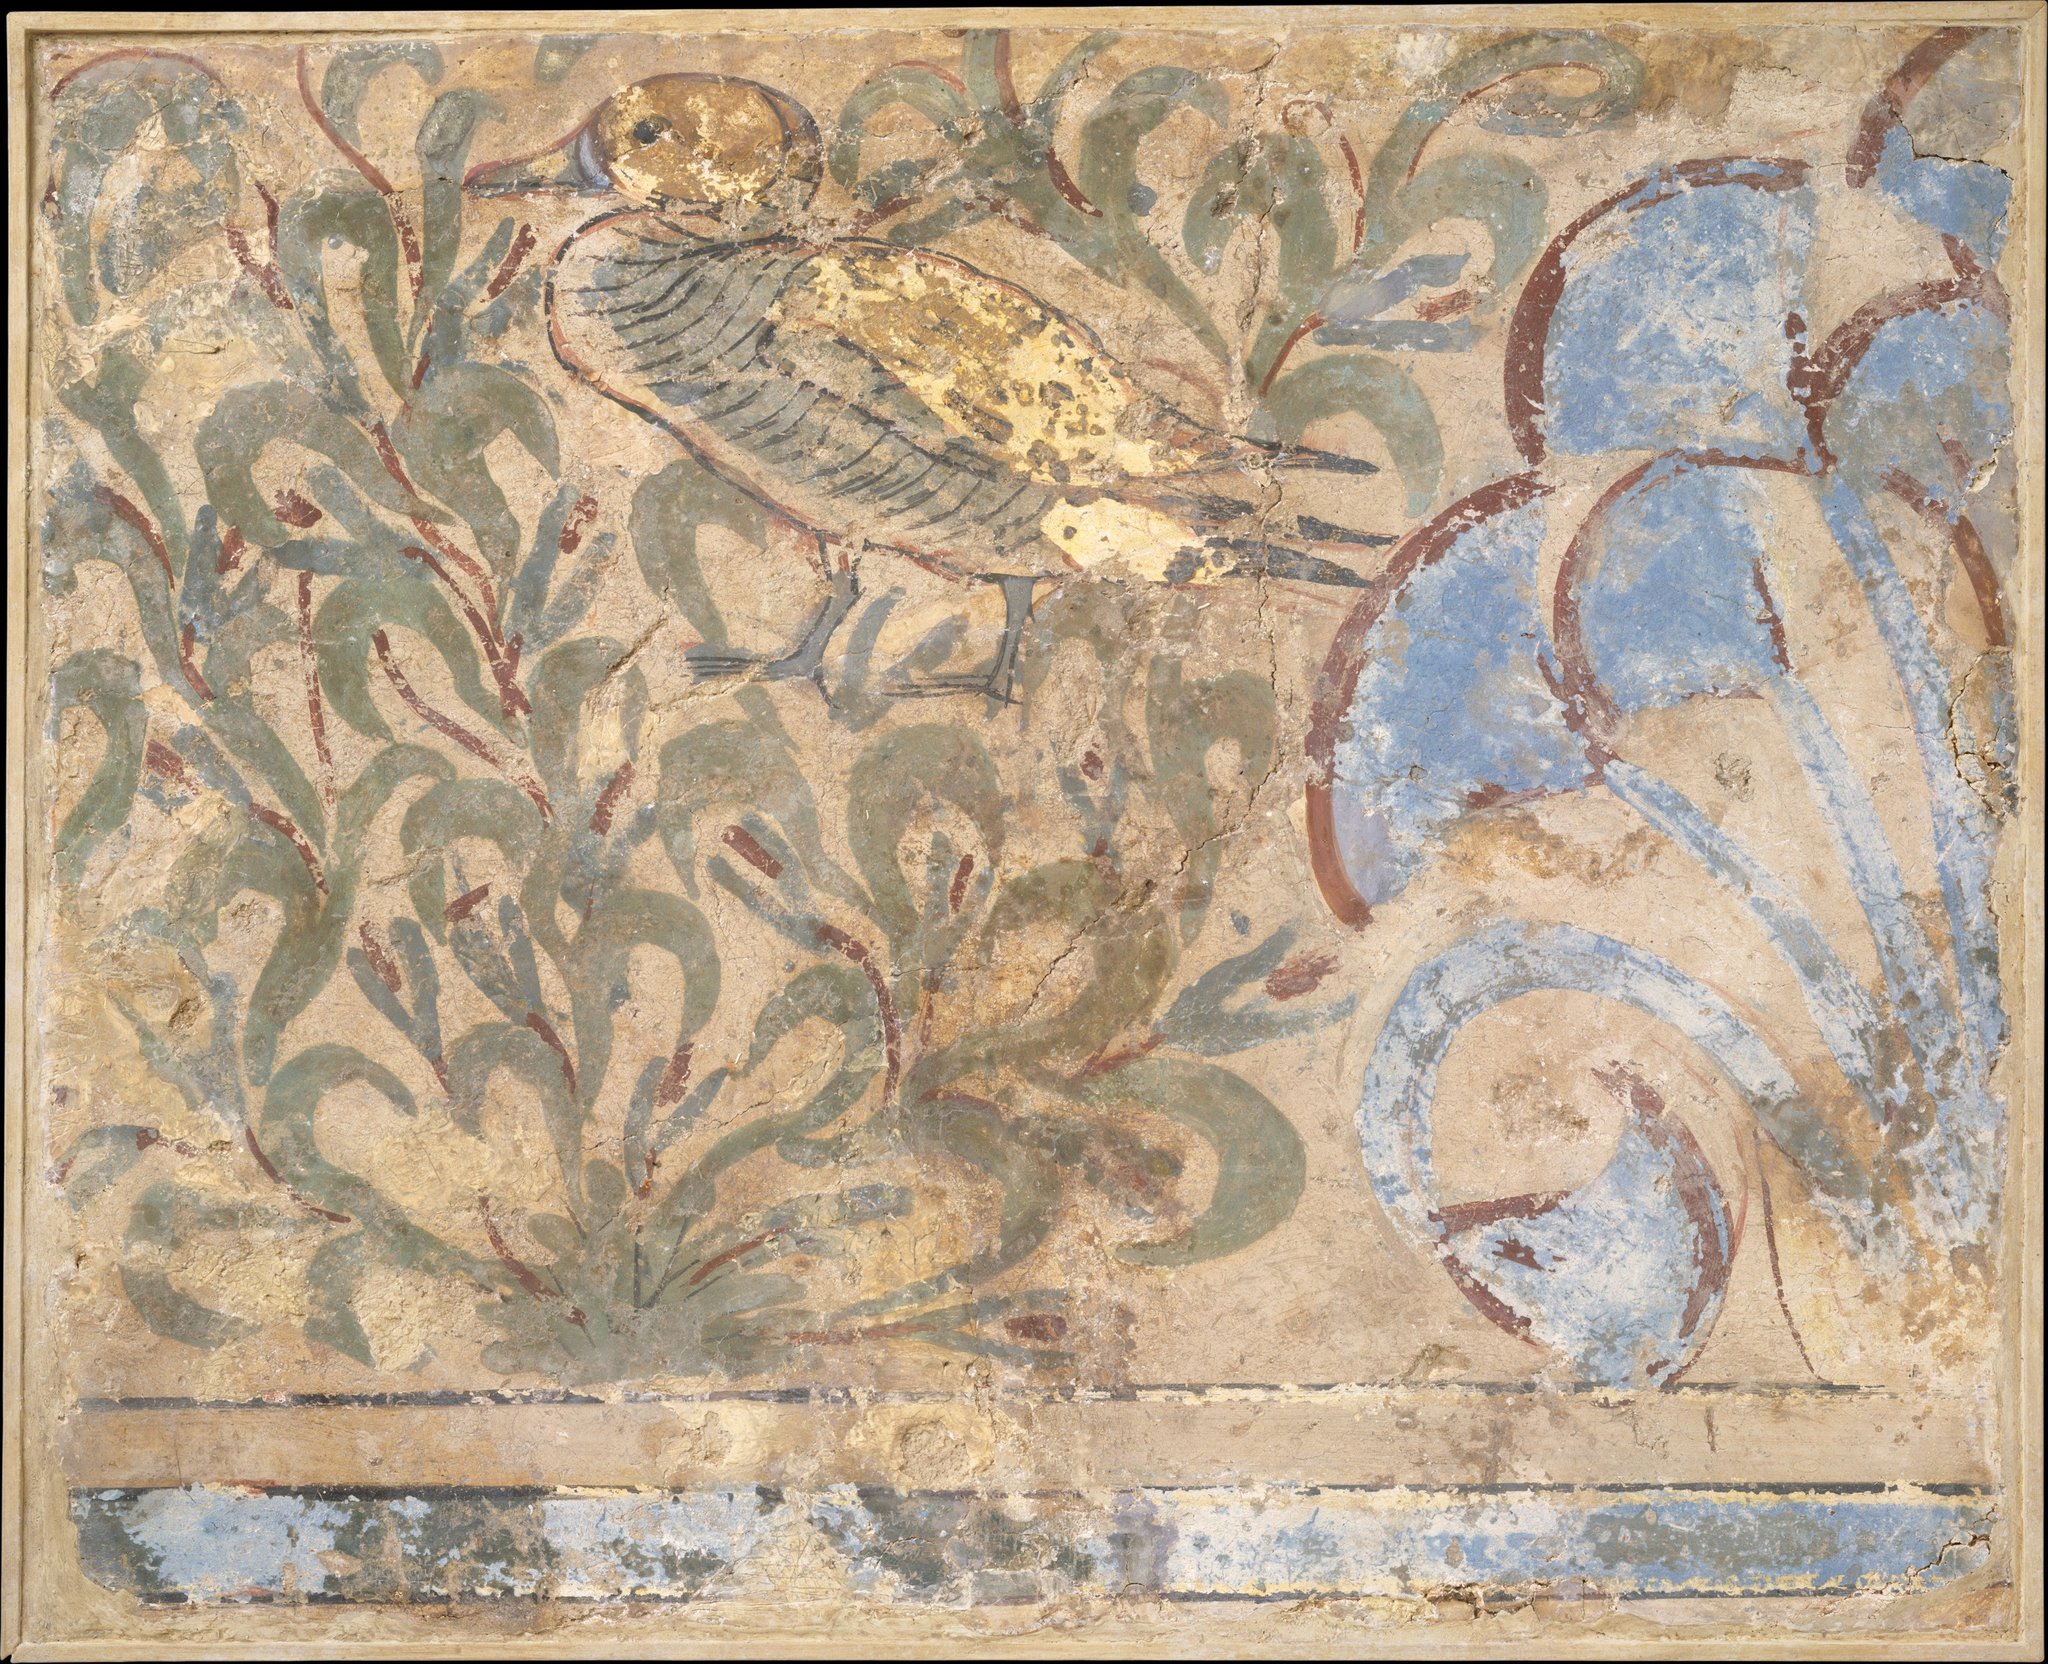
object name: pavement fragment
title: Painted Plaster Pavement Fragment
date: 1390-1352 BCE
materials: pigment, plaster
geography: egypt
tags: birds